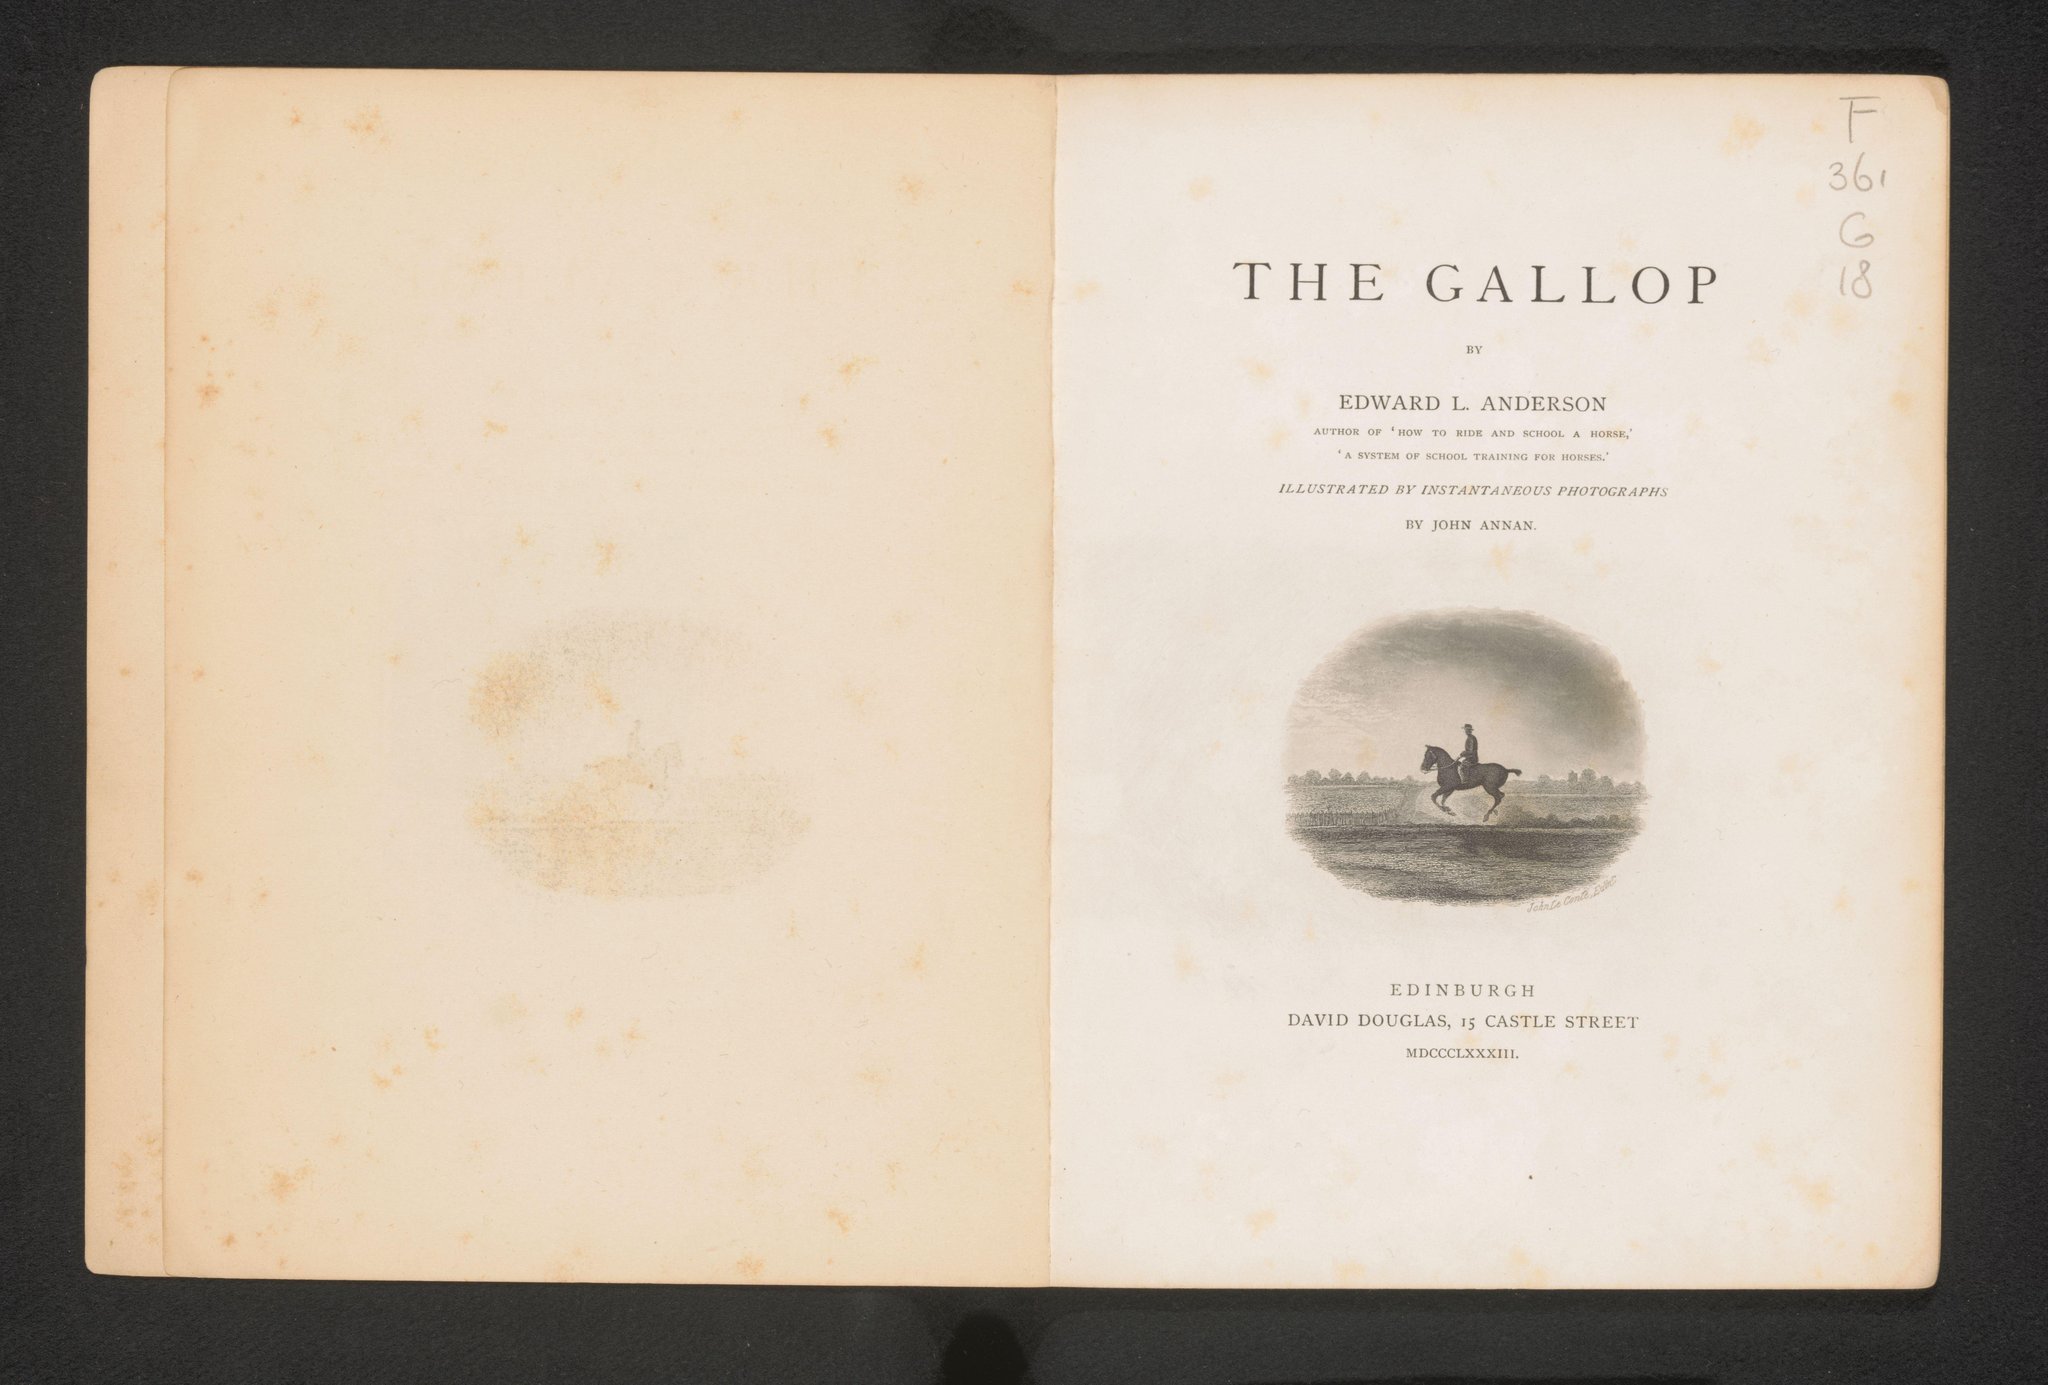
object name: book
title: The gallop / by Edward L. Anderson; illustrated by instantaneous photographs by John Annan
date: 1883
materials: cardboard, paper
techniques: lithograph, printing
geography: edinburgh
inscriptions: bookplate: ‘EX LIBRIS/ SOPHIA-VEREENIGING TOT/ BESCHERMING VAN DIEREN/ E. 526.’